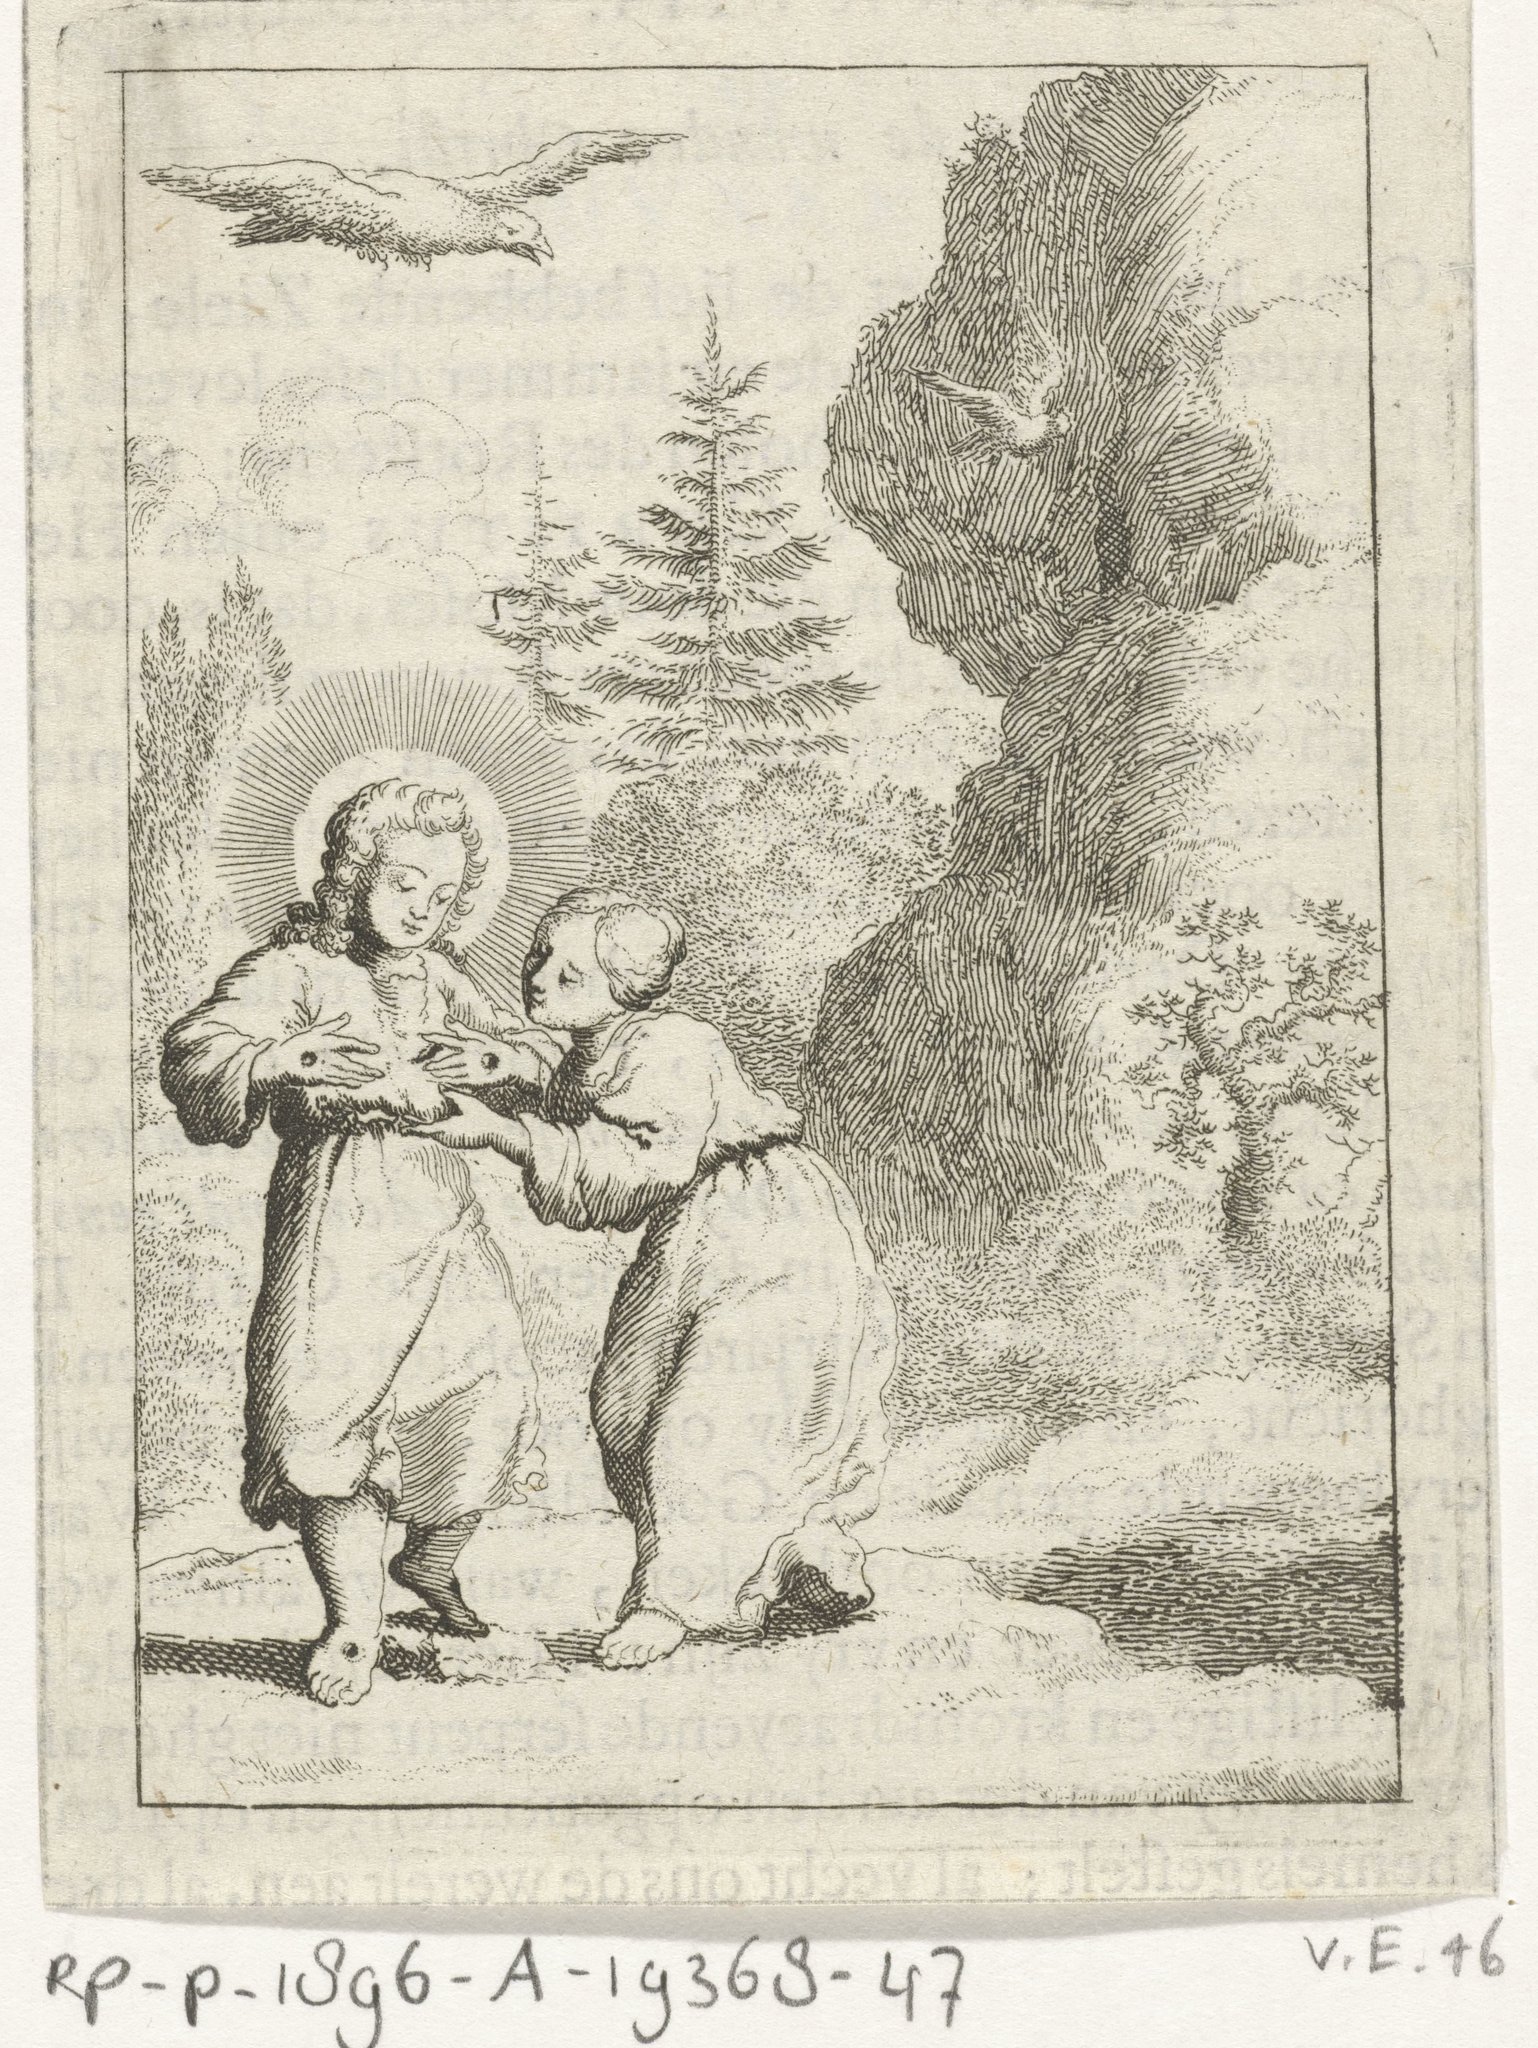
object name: book illustration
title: Jezus toont de wonden zijner handen aan de Ziel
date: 1678-1687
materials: paper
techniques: etching, letterpress printing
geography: amsterdam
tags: the soul, christ and the soul, christ showing his wounds, holy ghost represented as a dove (in flames)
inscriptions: collector's mark: Lugt 2228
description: Illustratie uit: Luyken, Jan. Jezus en de Ziel, 3 delen. Amsterdam: Pieter Arentsz II, 1678-1687. Tussen 1678-1744 verschenen van dit emblemataboek 10 edities.